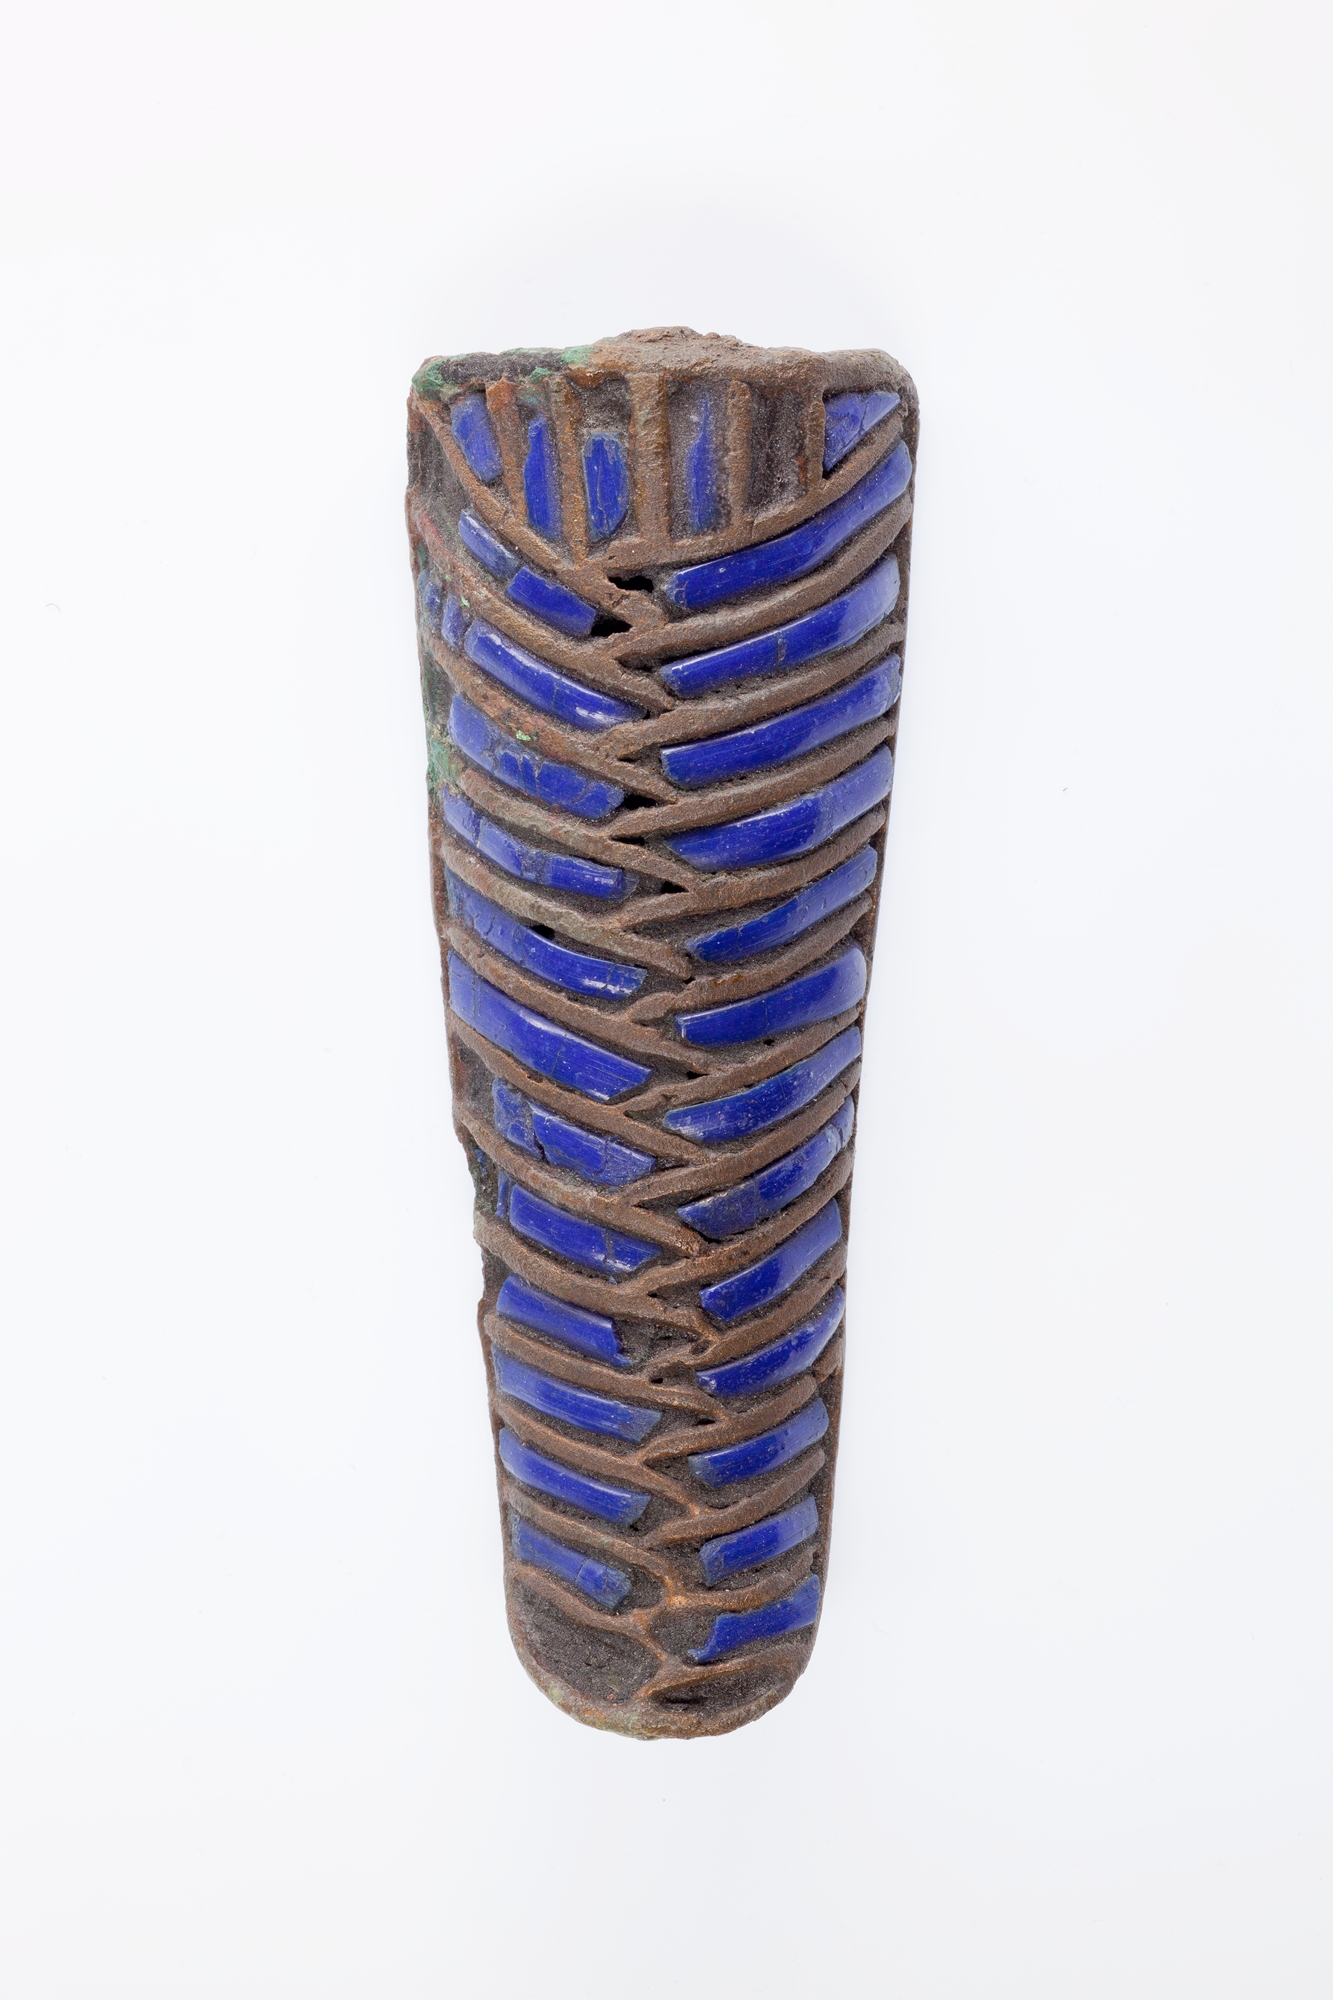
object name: statue attachment, beard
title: Beard from a large statue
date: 1070-664 BCE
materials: alloy, glass, gold leaf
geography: egypt